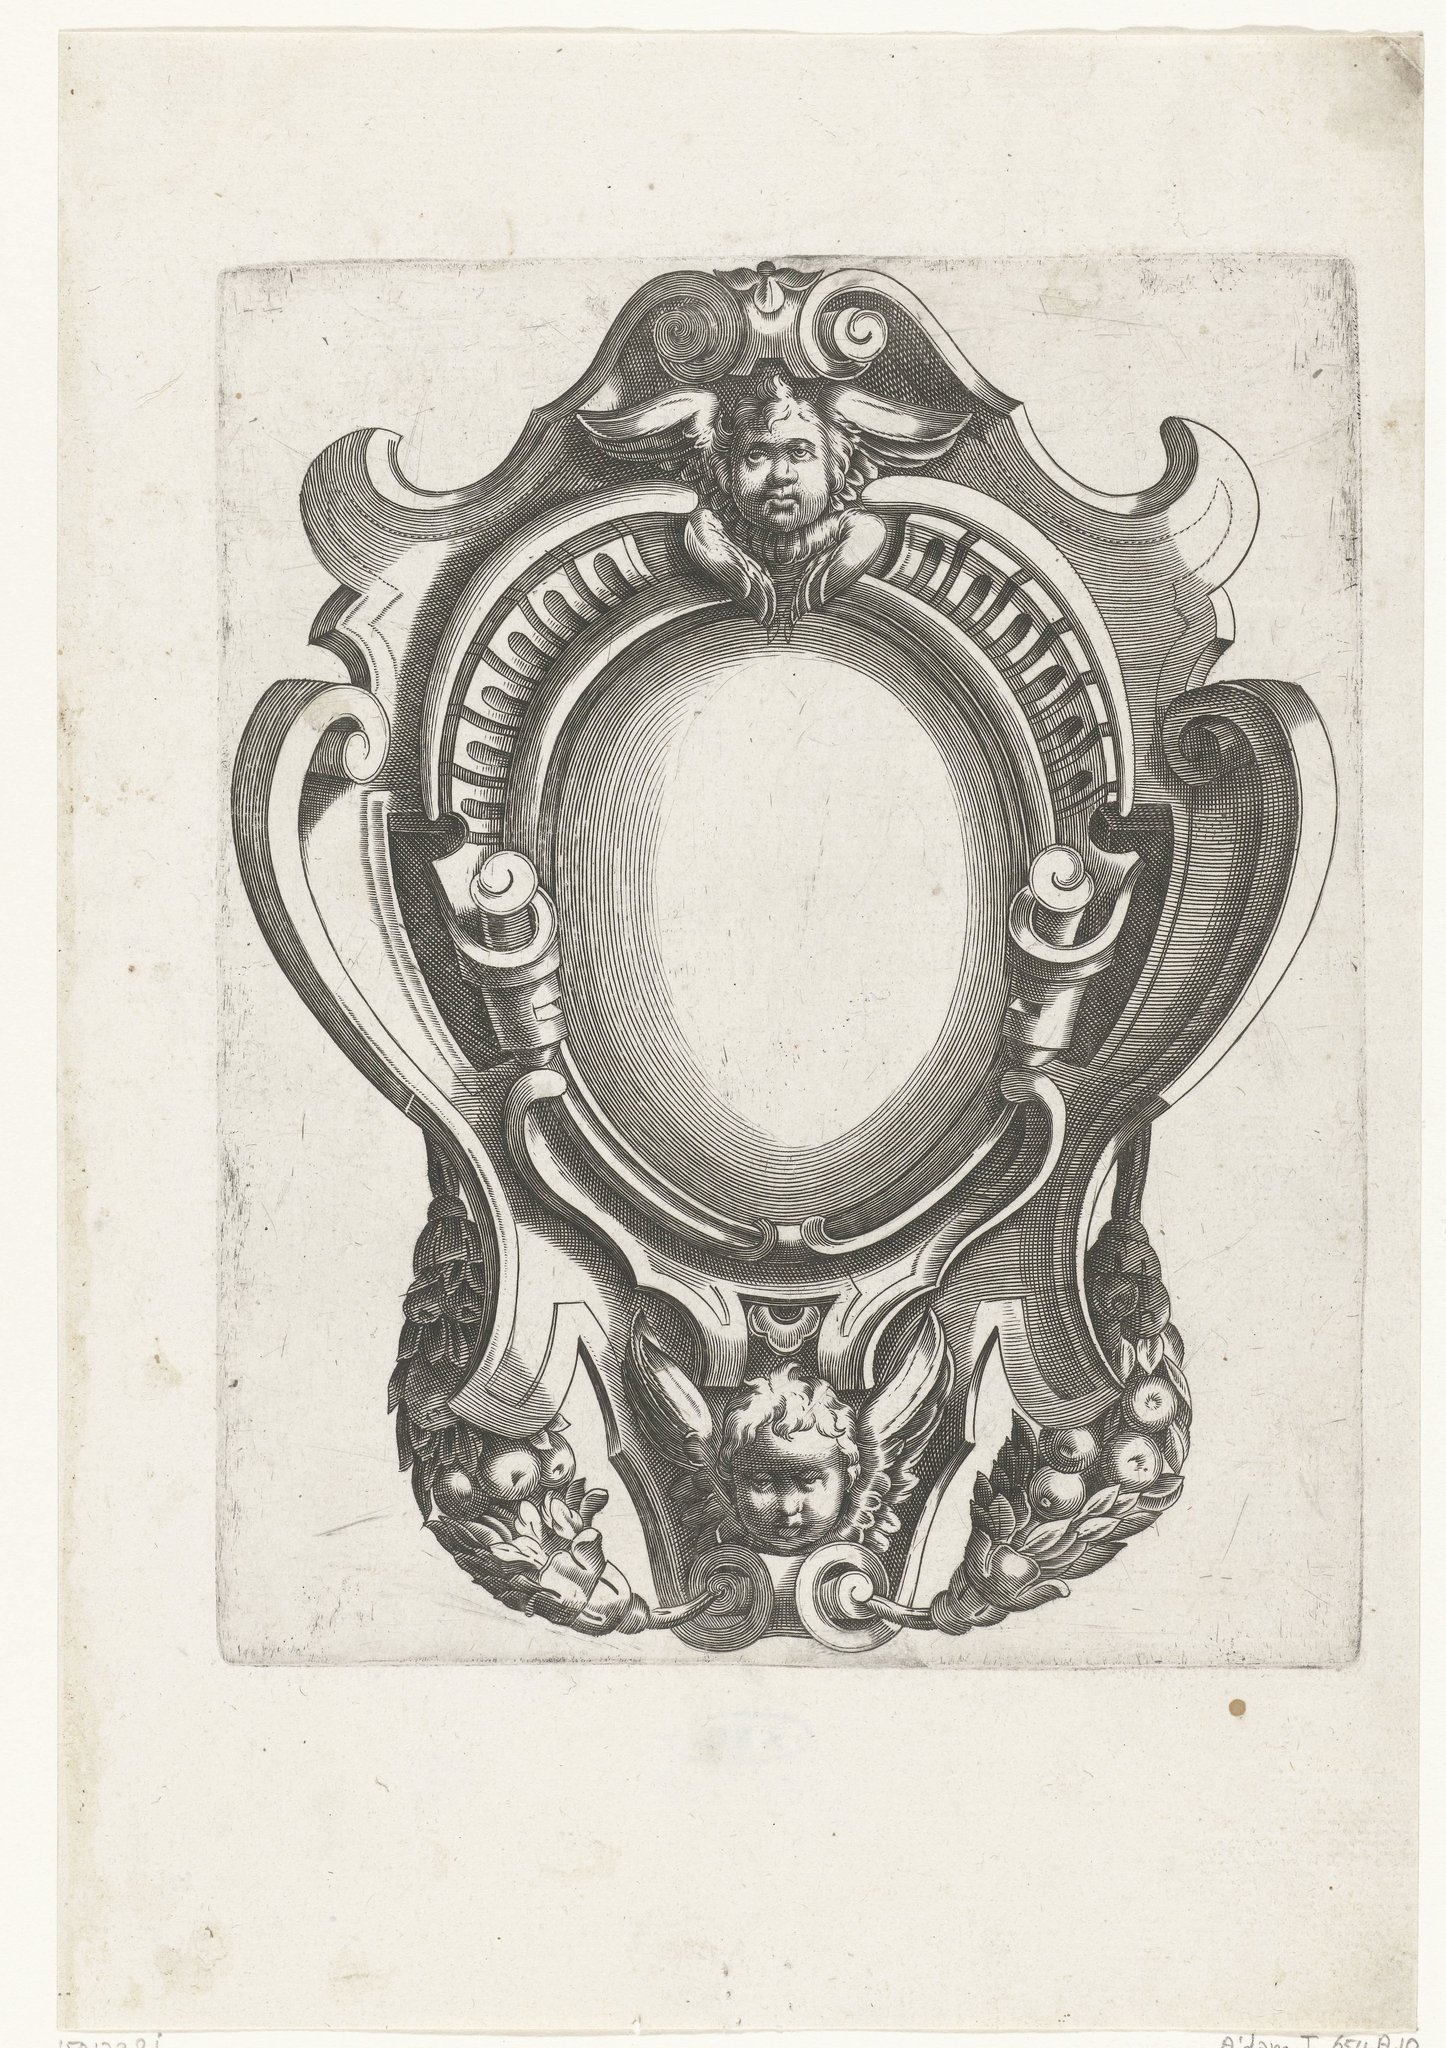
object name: print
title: Cartouches in omlijstingen van rolwerk met grotesken, guirlandes en mascarons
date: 1628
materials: paper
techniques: engraving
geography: france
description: Tegenzijdige kopie naar blad 11 uit serie met cartouches in omlijstingen van rolwerk met grotesken, guirlandes en mascarons uitgegeven door Pierre Mariette.